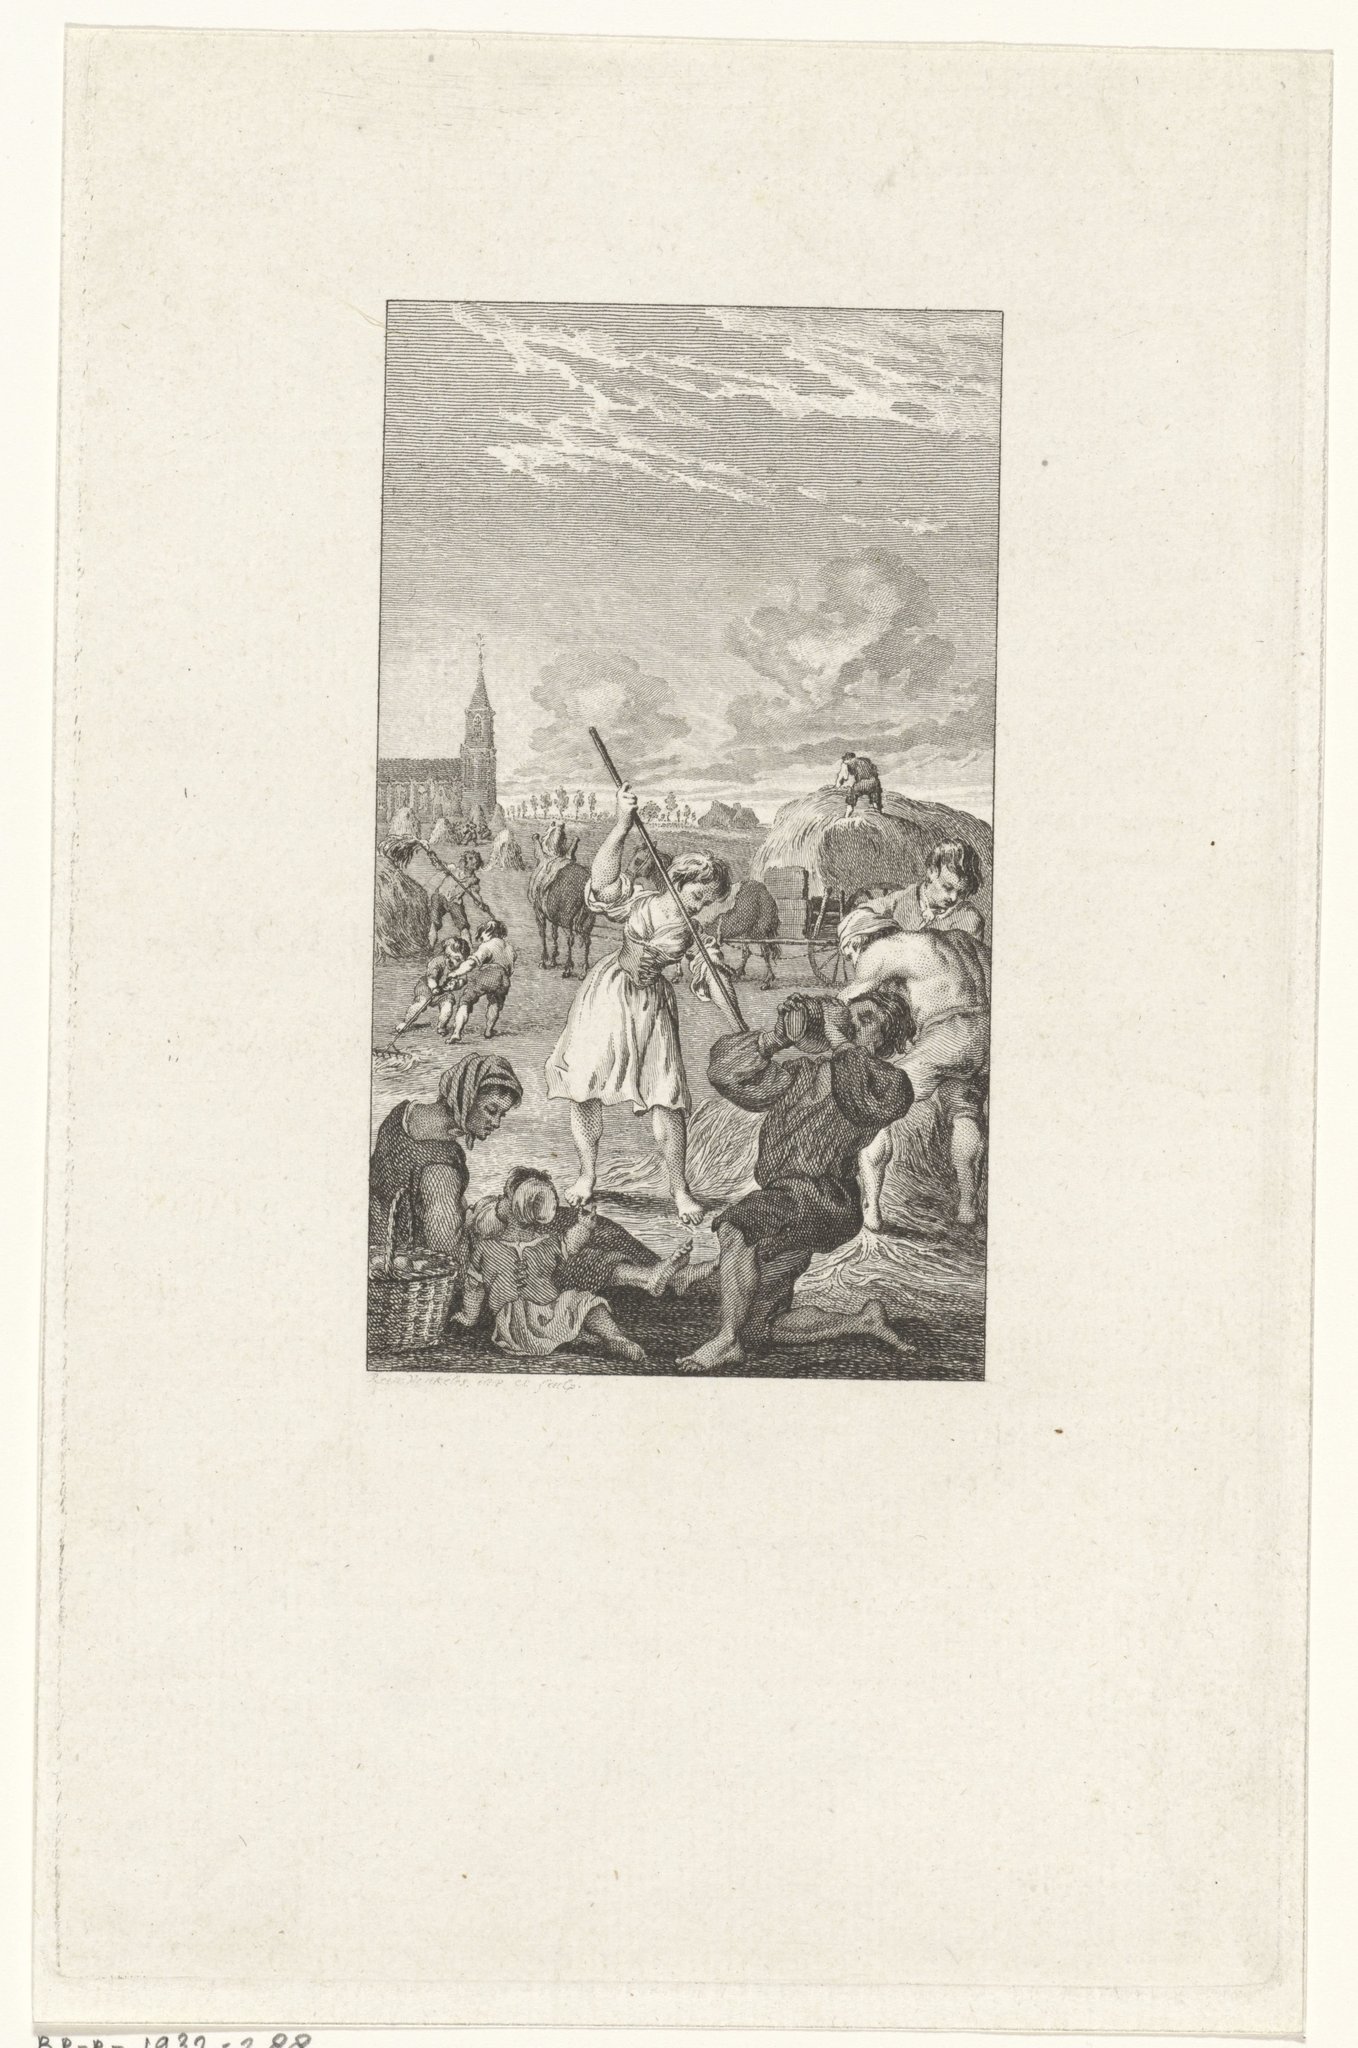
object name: print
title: Dorpelingen oogsten hooi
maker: reinier vinkeles (i)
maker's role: draughtsman, print maker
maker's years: 1741-1816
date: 1751-1816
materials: paper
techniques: engraving, etching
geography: amsterdam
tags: harvest, church (exterior), hay-wagon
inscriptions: collector's mark: Lugt 2228, collector's mark: Lugt 2760